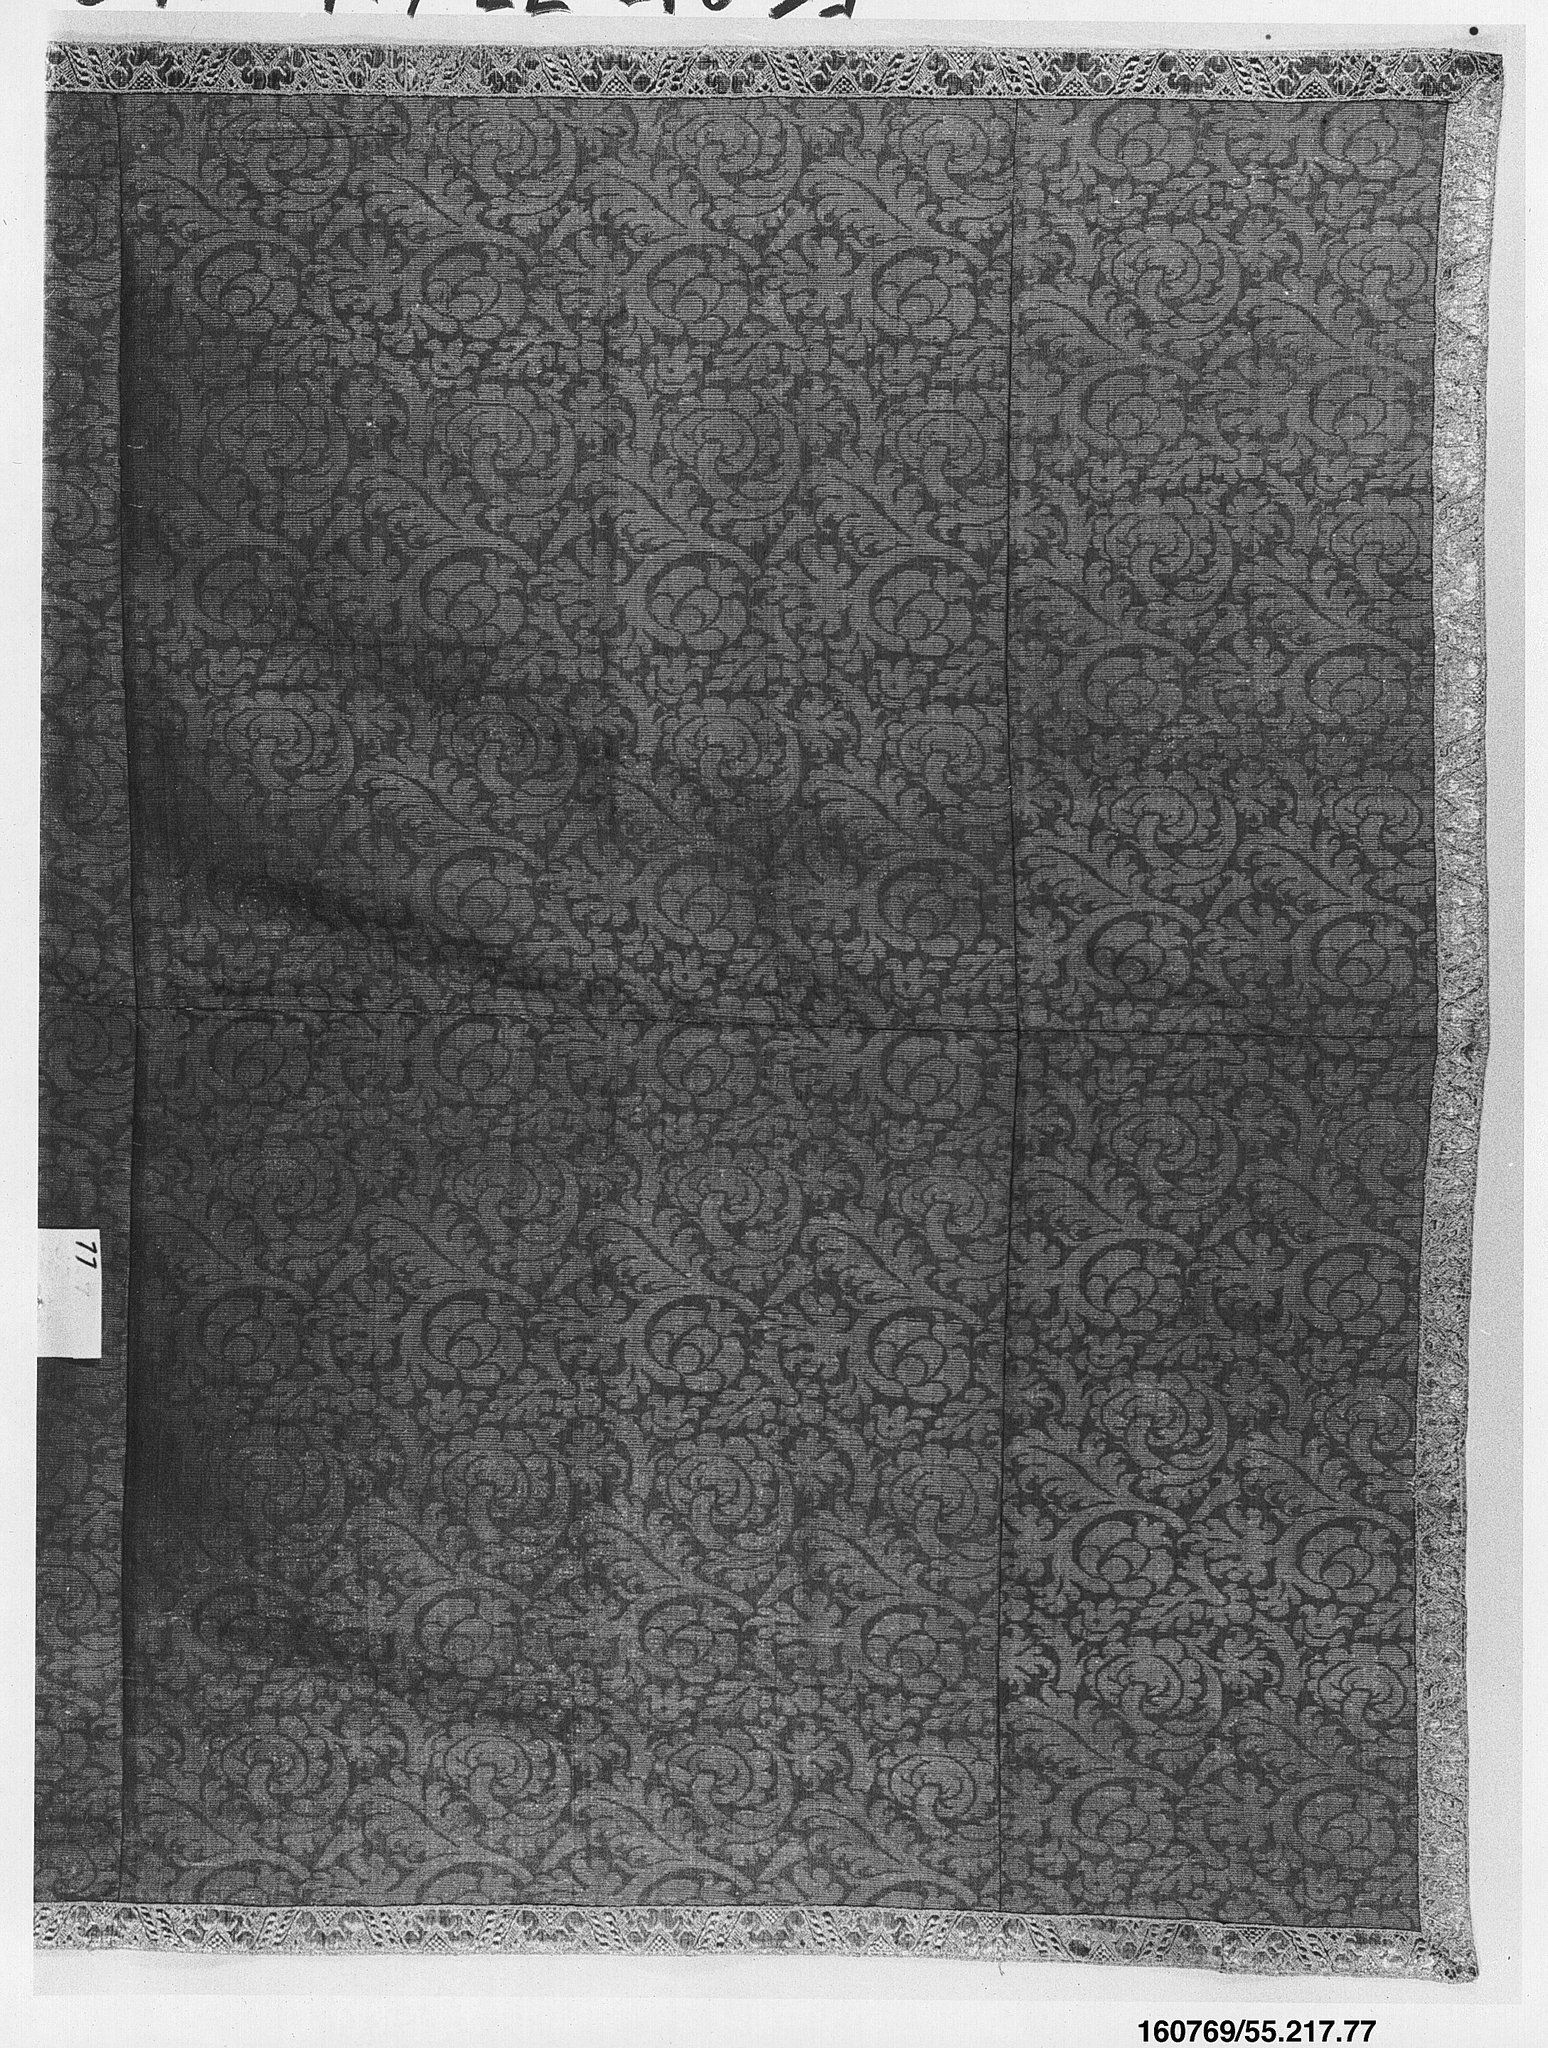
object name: panel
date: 1601-1700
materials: metal thread, silk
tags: flowers,leaves